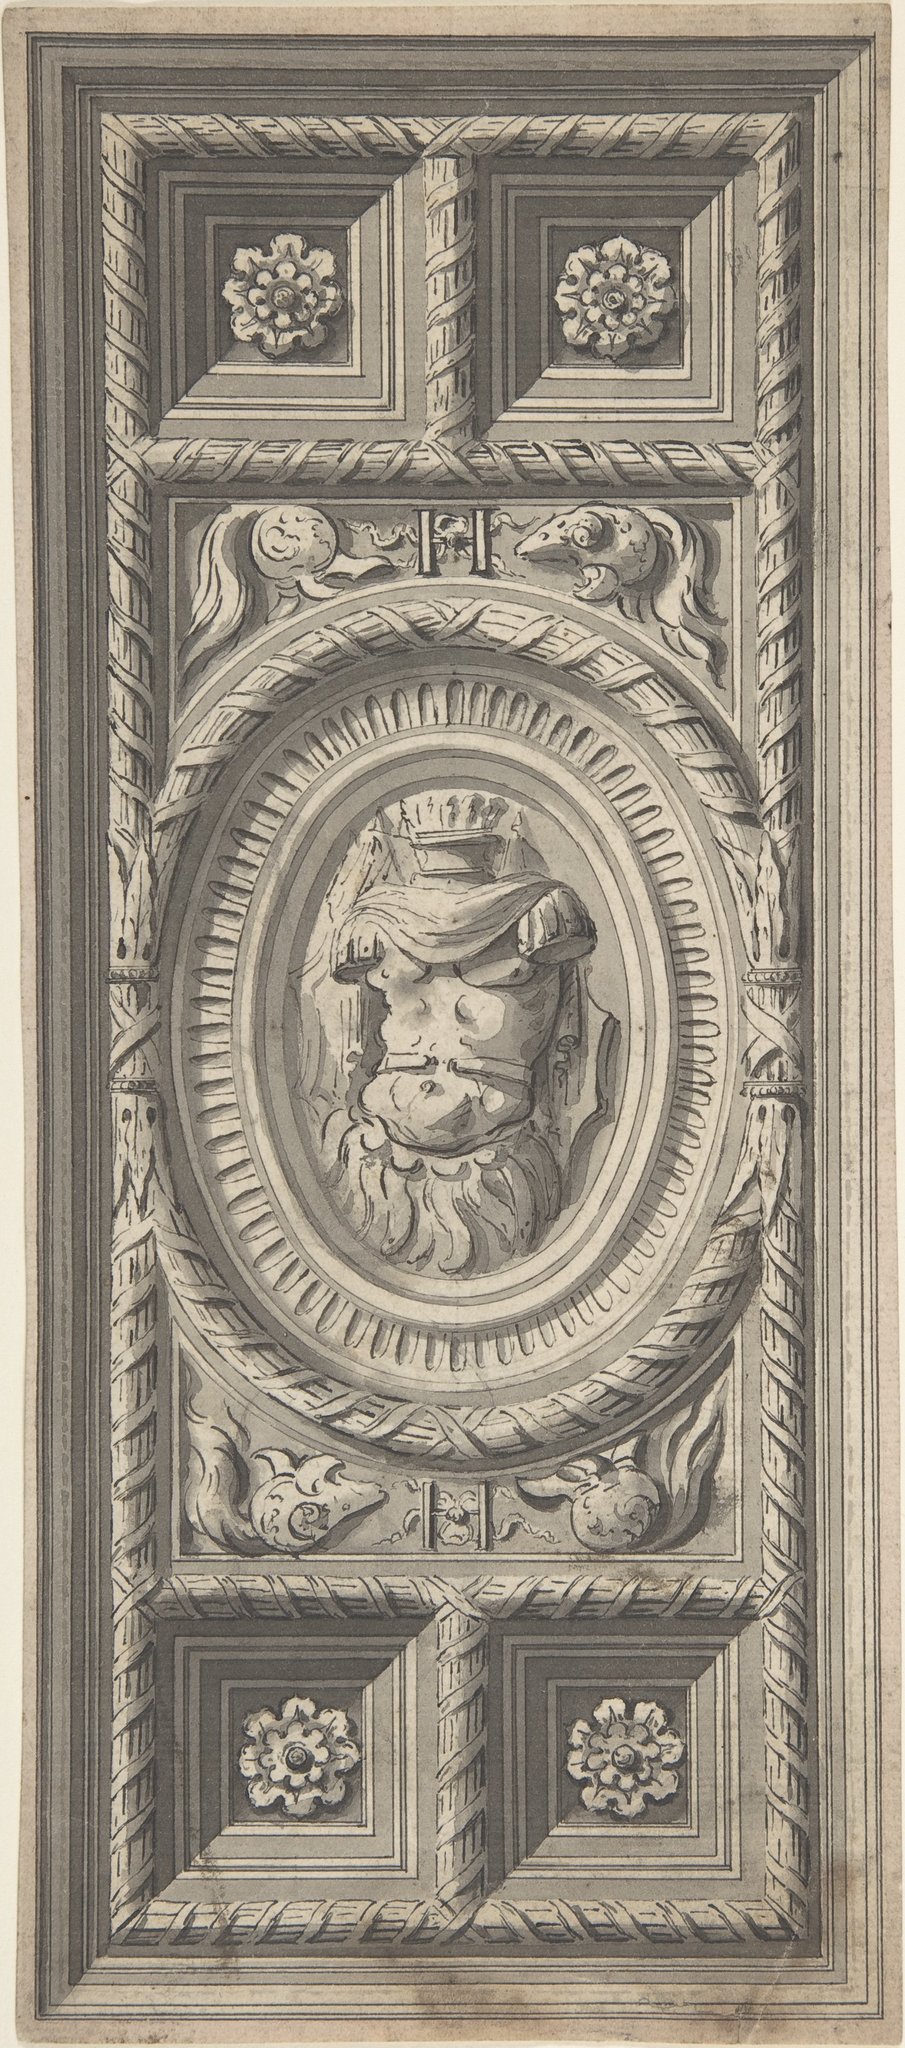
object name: drawing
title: Study of the Henri II Staircase Ceiling at the Louvre Palace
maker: anonymous, french, 18th century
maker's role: artist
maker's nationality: french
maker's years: 1700-1800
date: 1767-1800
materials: ink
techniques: brush, pen, wash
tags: palaces,flowers